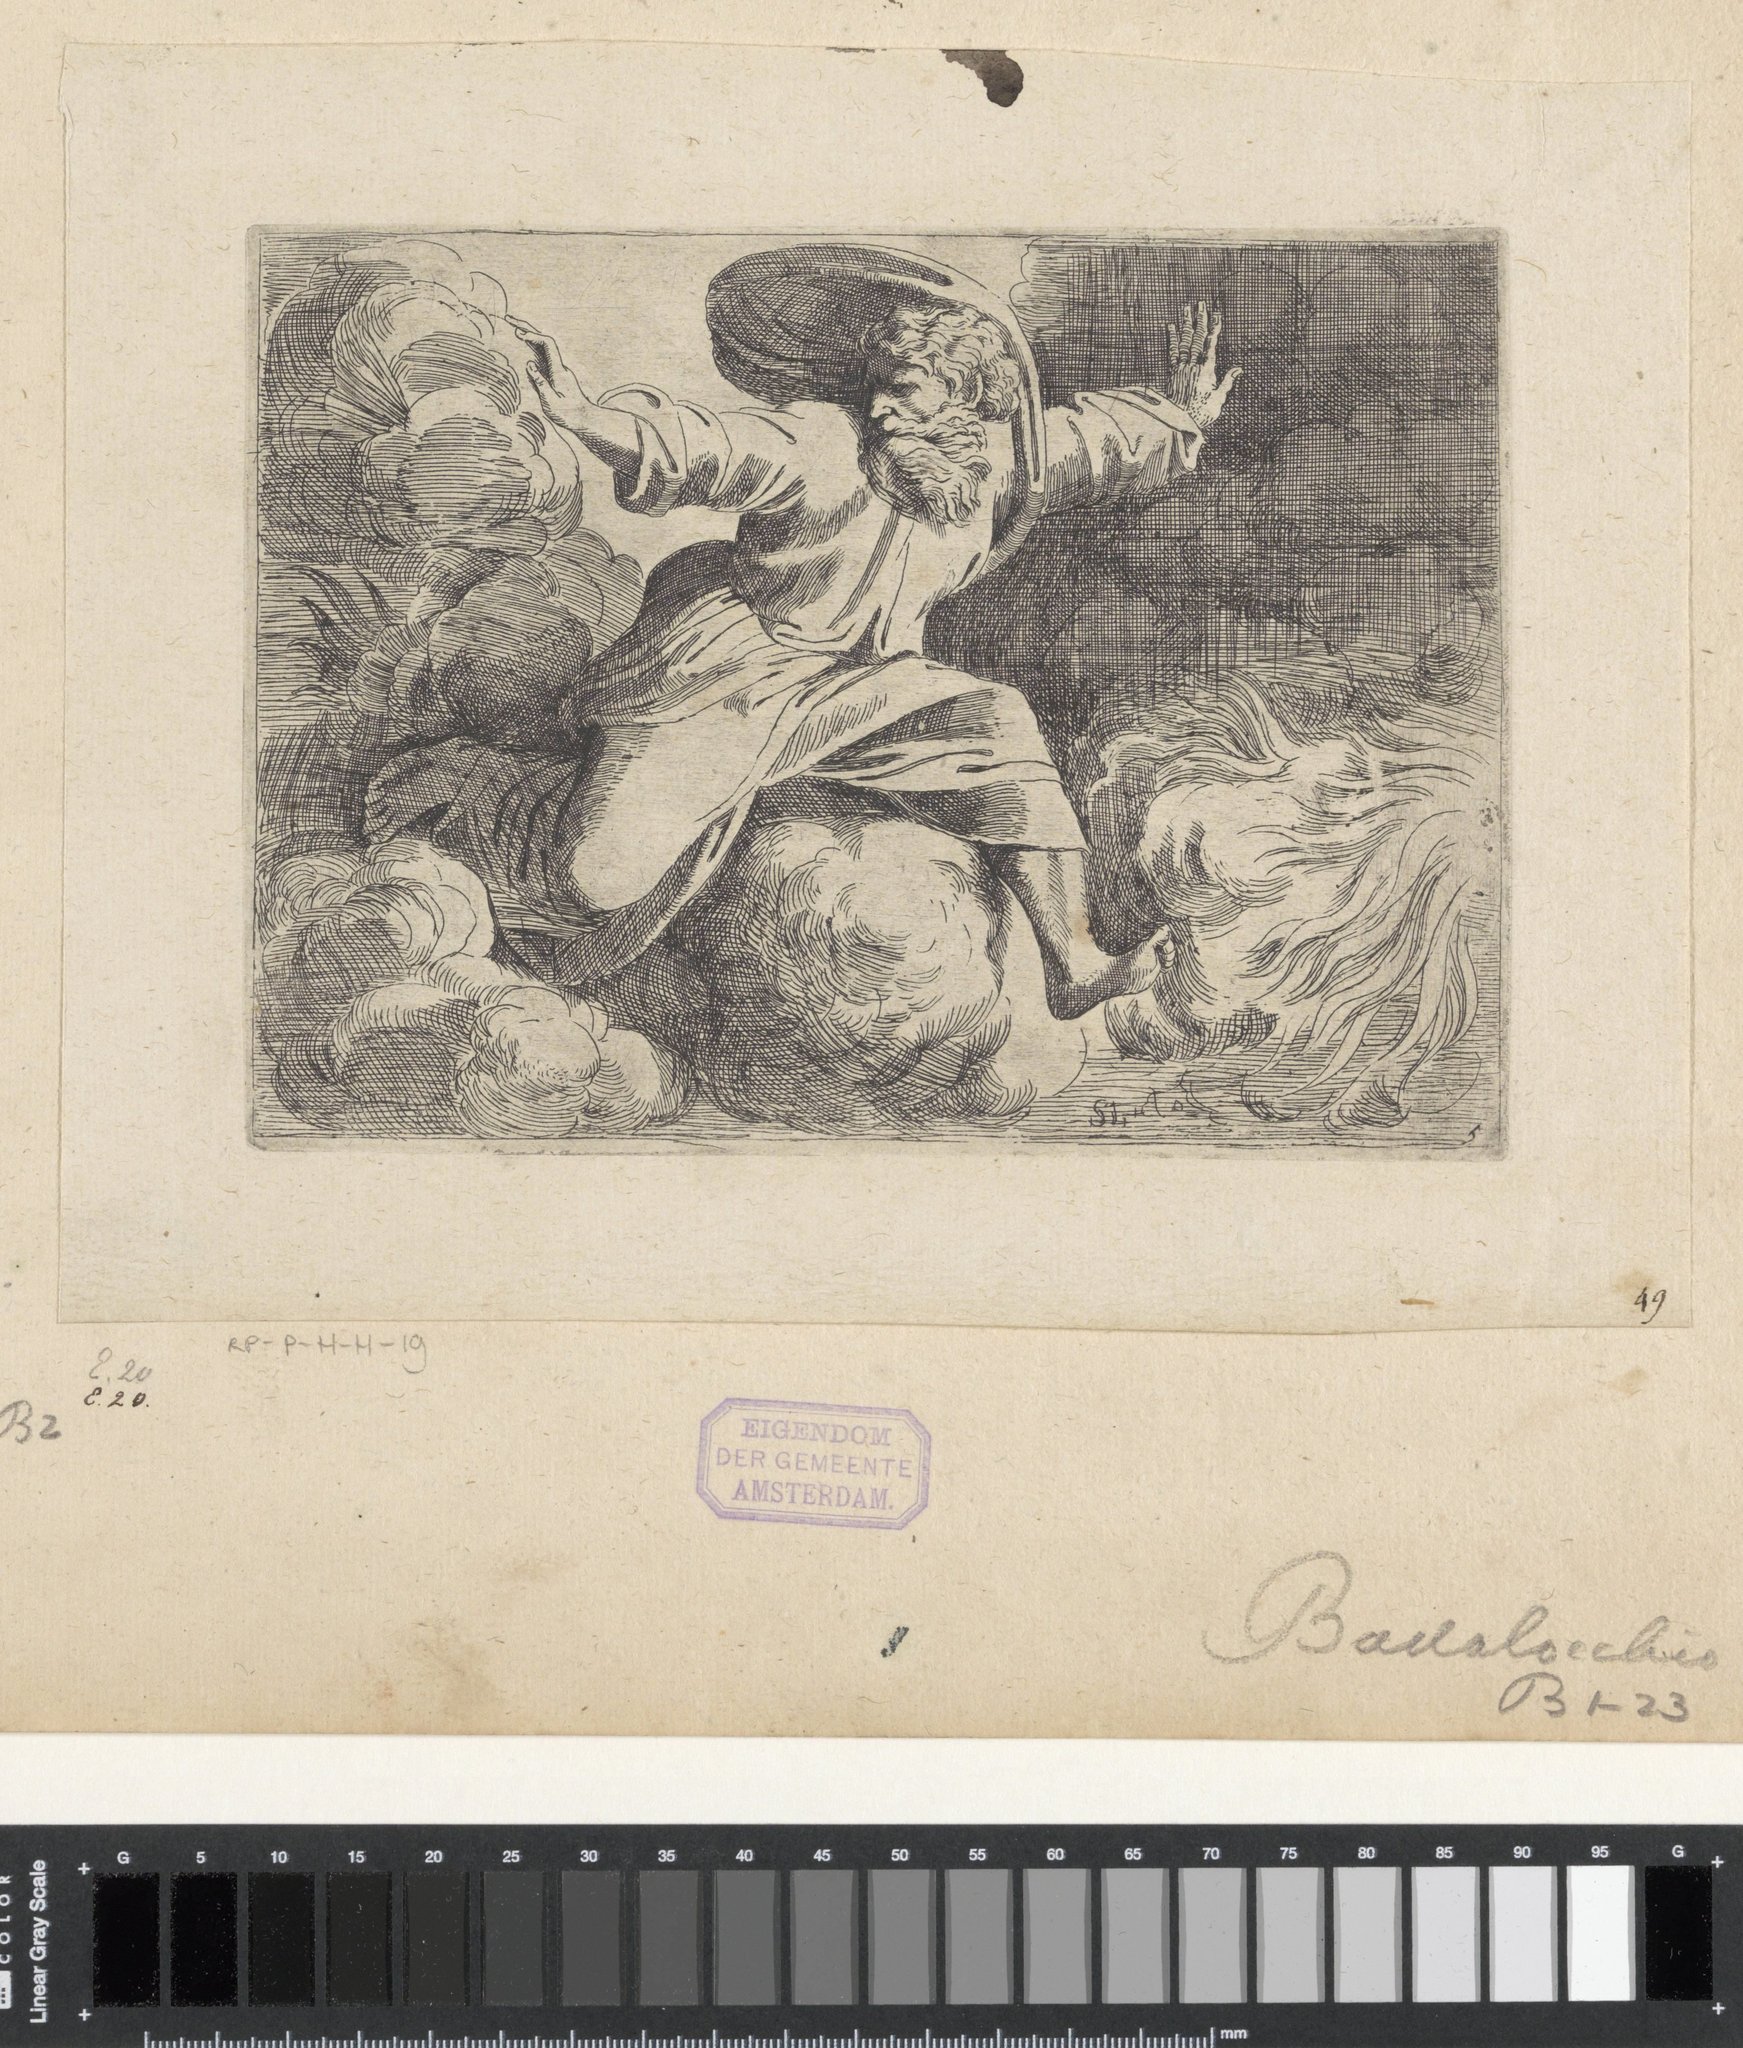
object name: print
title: God scheidt het licht van de duisternis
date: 1607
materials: paper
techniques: etching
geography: vatican city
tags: division of light and darkness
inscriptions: collector's mark: Lugt 11, collector's mark: ‘Hinloopen’, number: ‘49’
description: Op een blad geplakt met rechtsboven handgeschreven in pen in bruin: 169. Prent uit een reeks van 54 genummerde prenten naar schilderingen in de Loggia van Rafael in het Vaticaan.